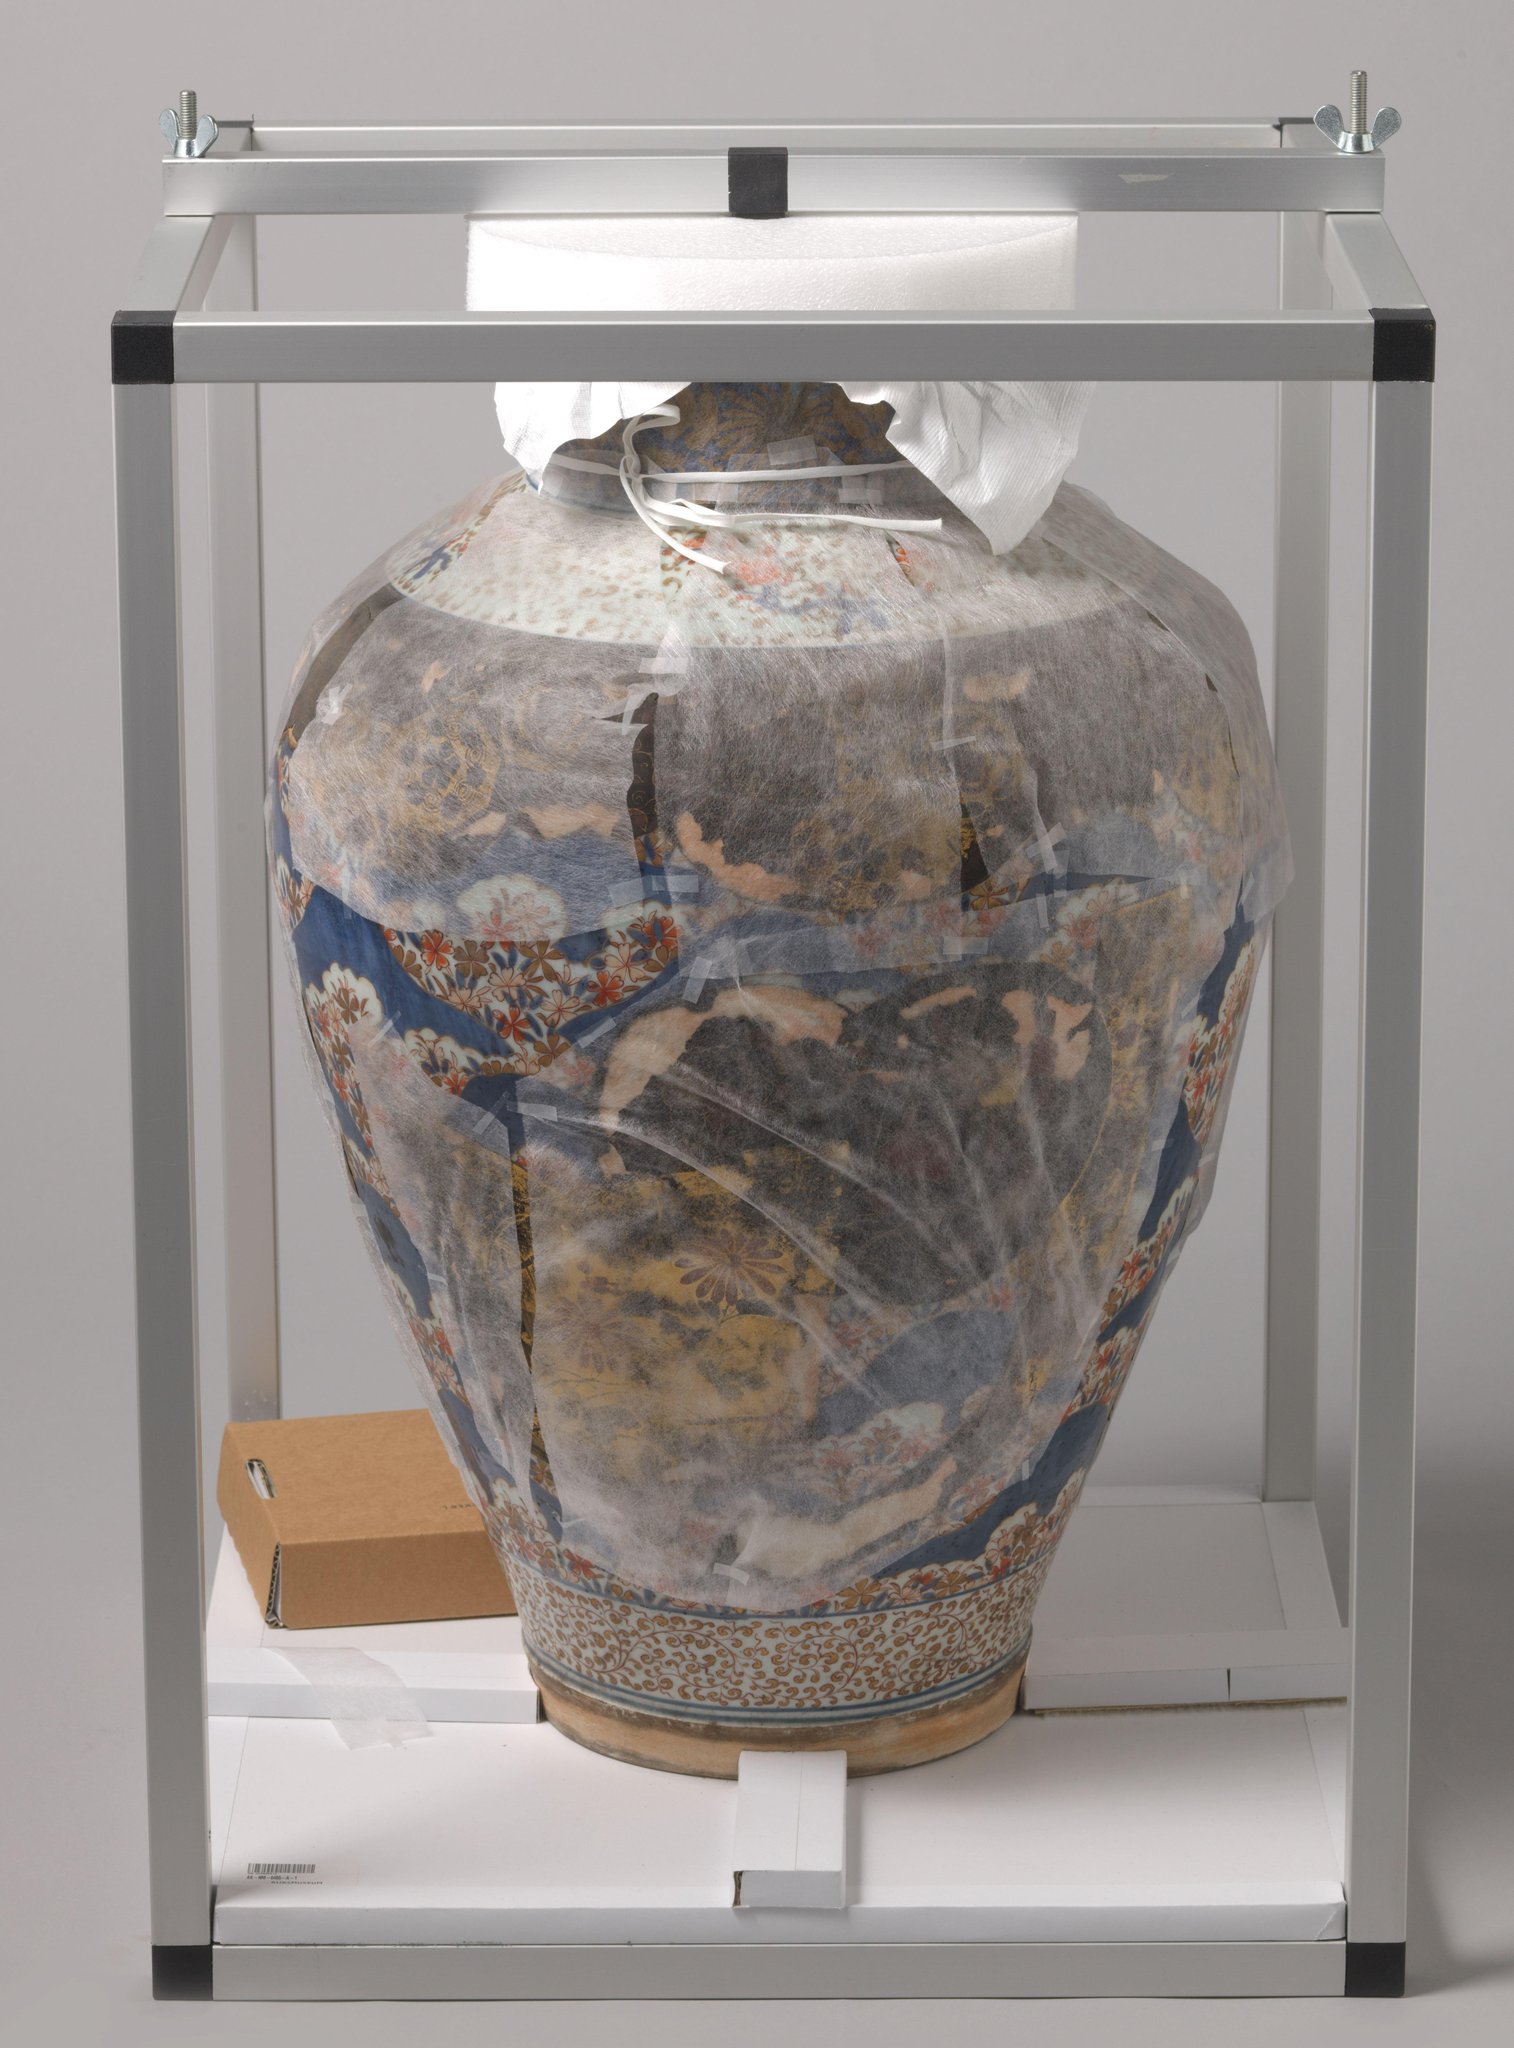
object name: dekselvaas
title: Dekselvaas met Imari-decoratie en lakwerk, met deksel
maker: Anonymous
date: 1700-1725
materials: glaze, lacquer, paint, porcelain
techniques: firing, gilding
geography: japan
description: Eivormige vaas met een bolle deksel met recht uitstekende dekselrand en bekroond met een leeuw. Beschilderd in onderglazuur blauw, rode emails en goud met wolken en bloemtakken. Hierin ziin velden uitgespaard die zijn bedekt met lakwerk met bloemen.